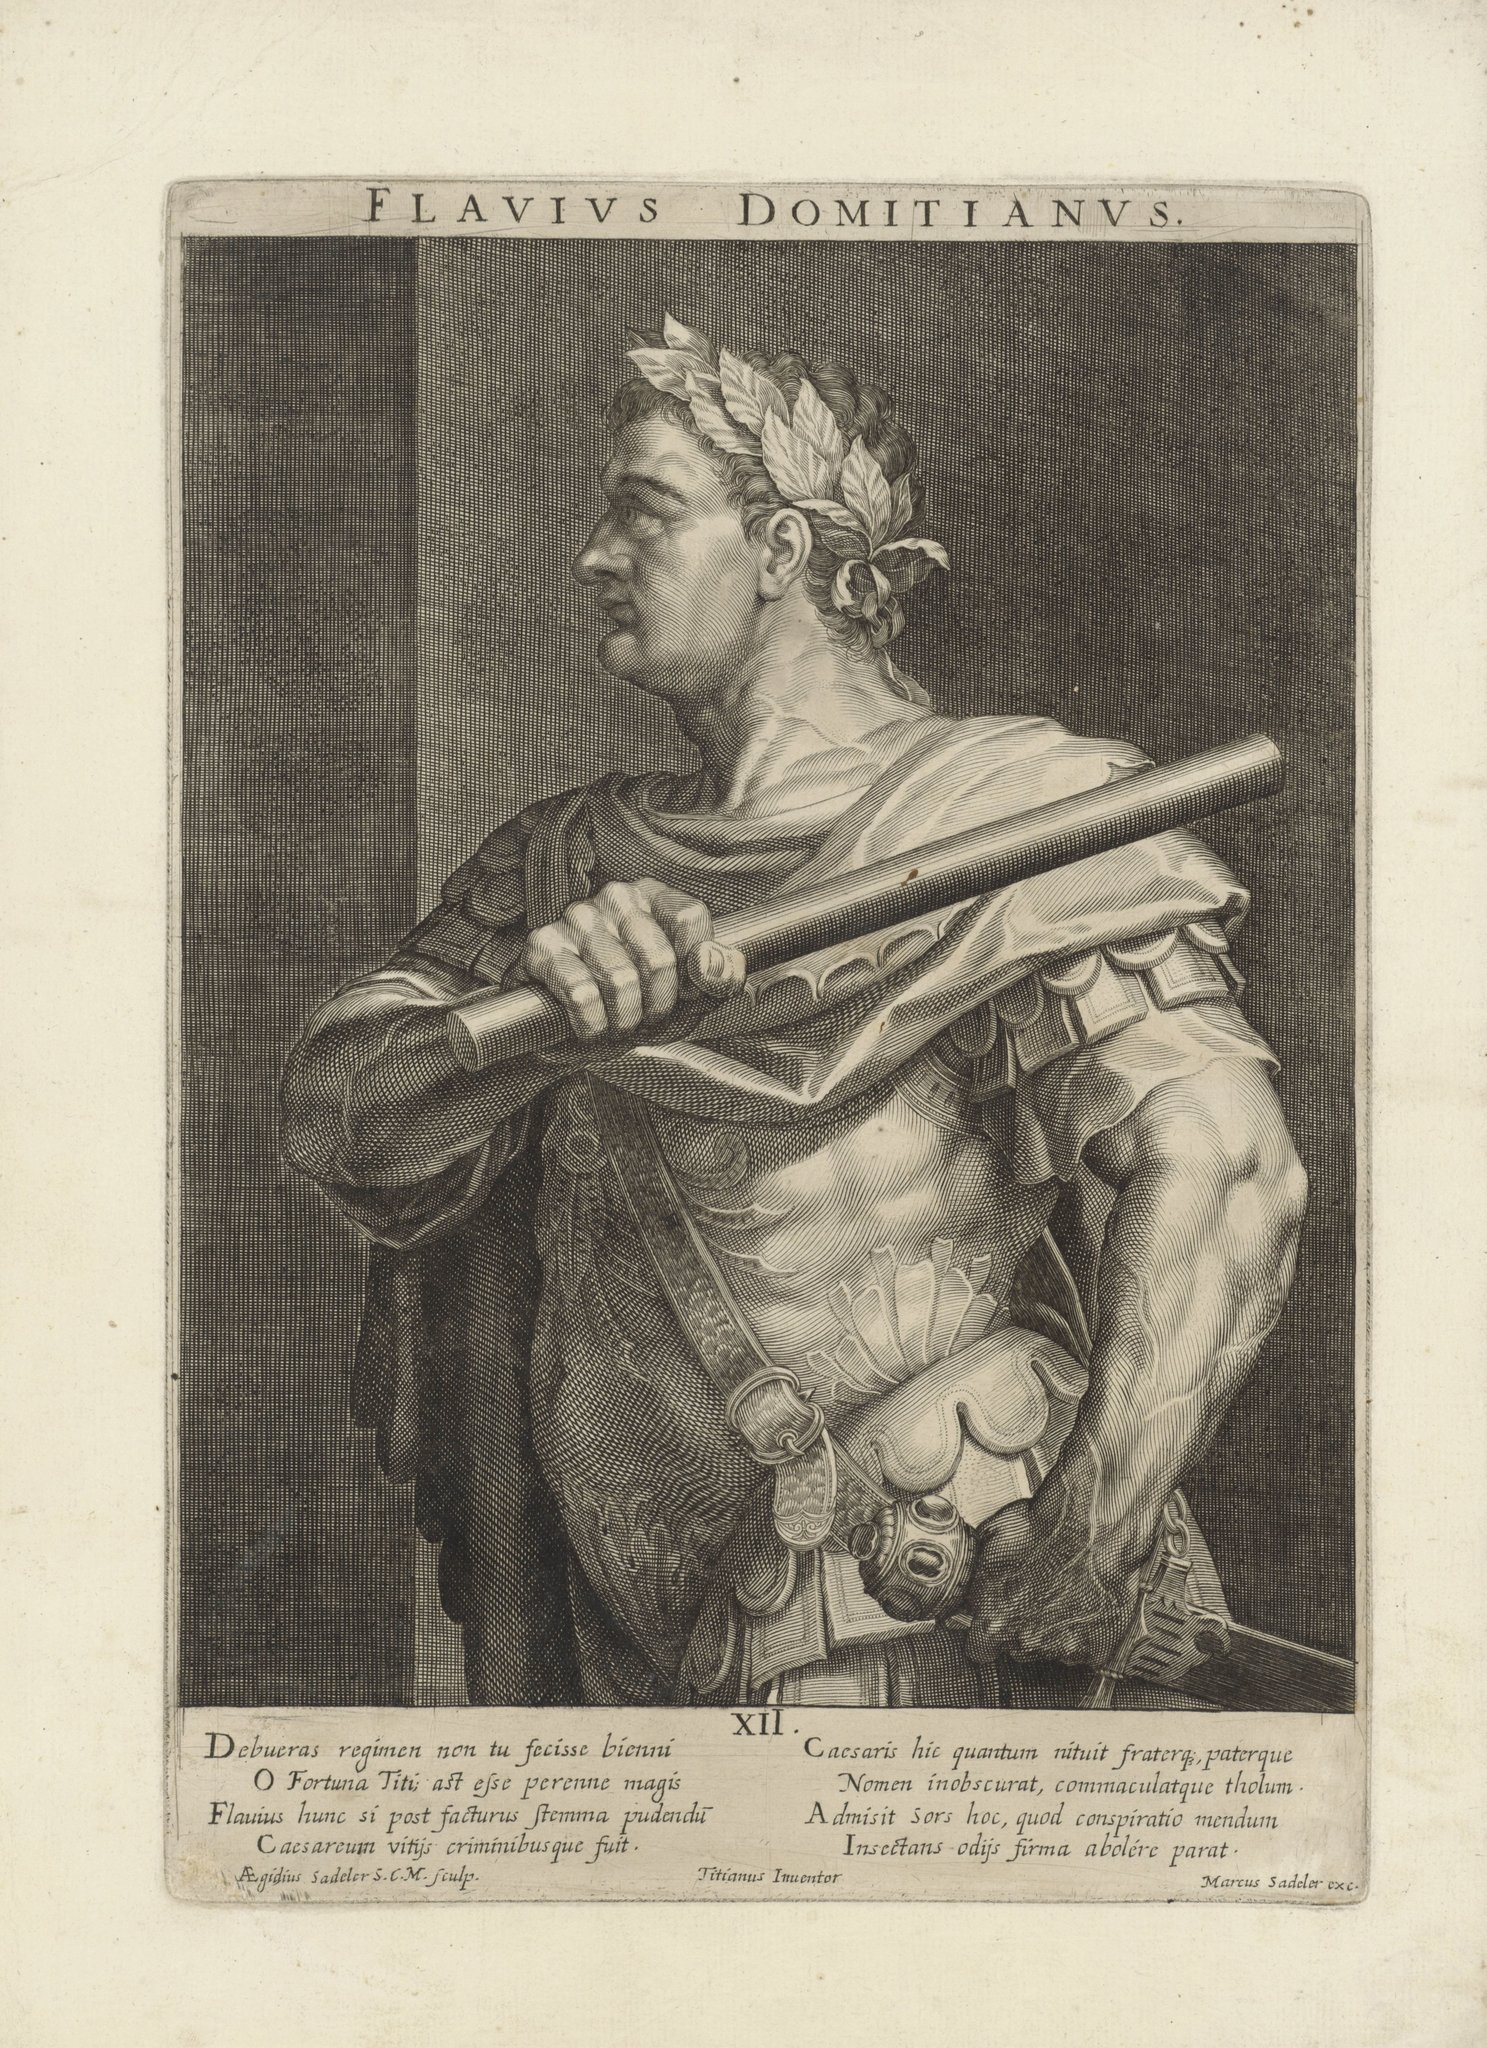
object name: print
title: Portret van keizer Domitianus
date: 1597-1629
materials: paper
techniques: engraving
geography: venice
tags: keizer, domitianus (keizer van het romeinse rijk)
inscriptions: collector's mark: Lugt 240